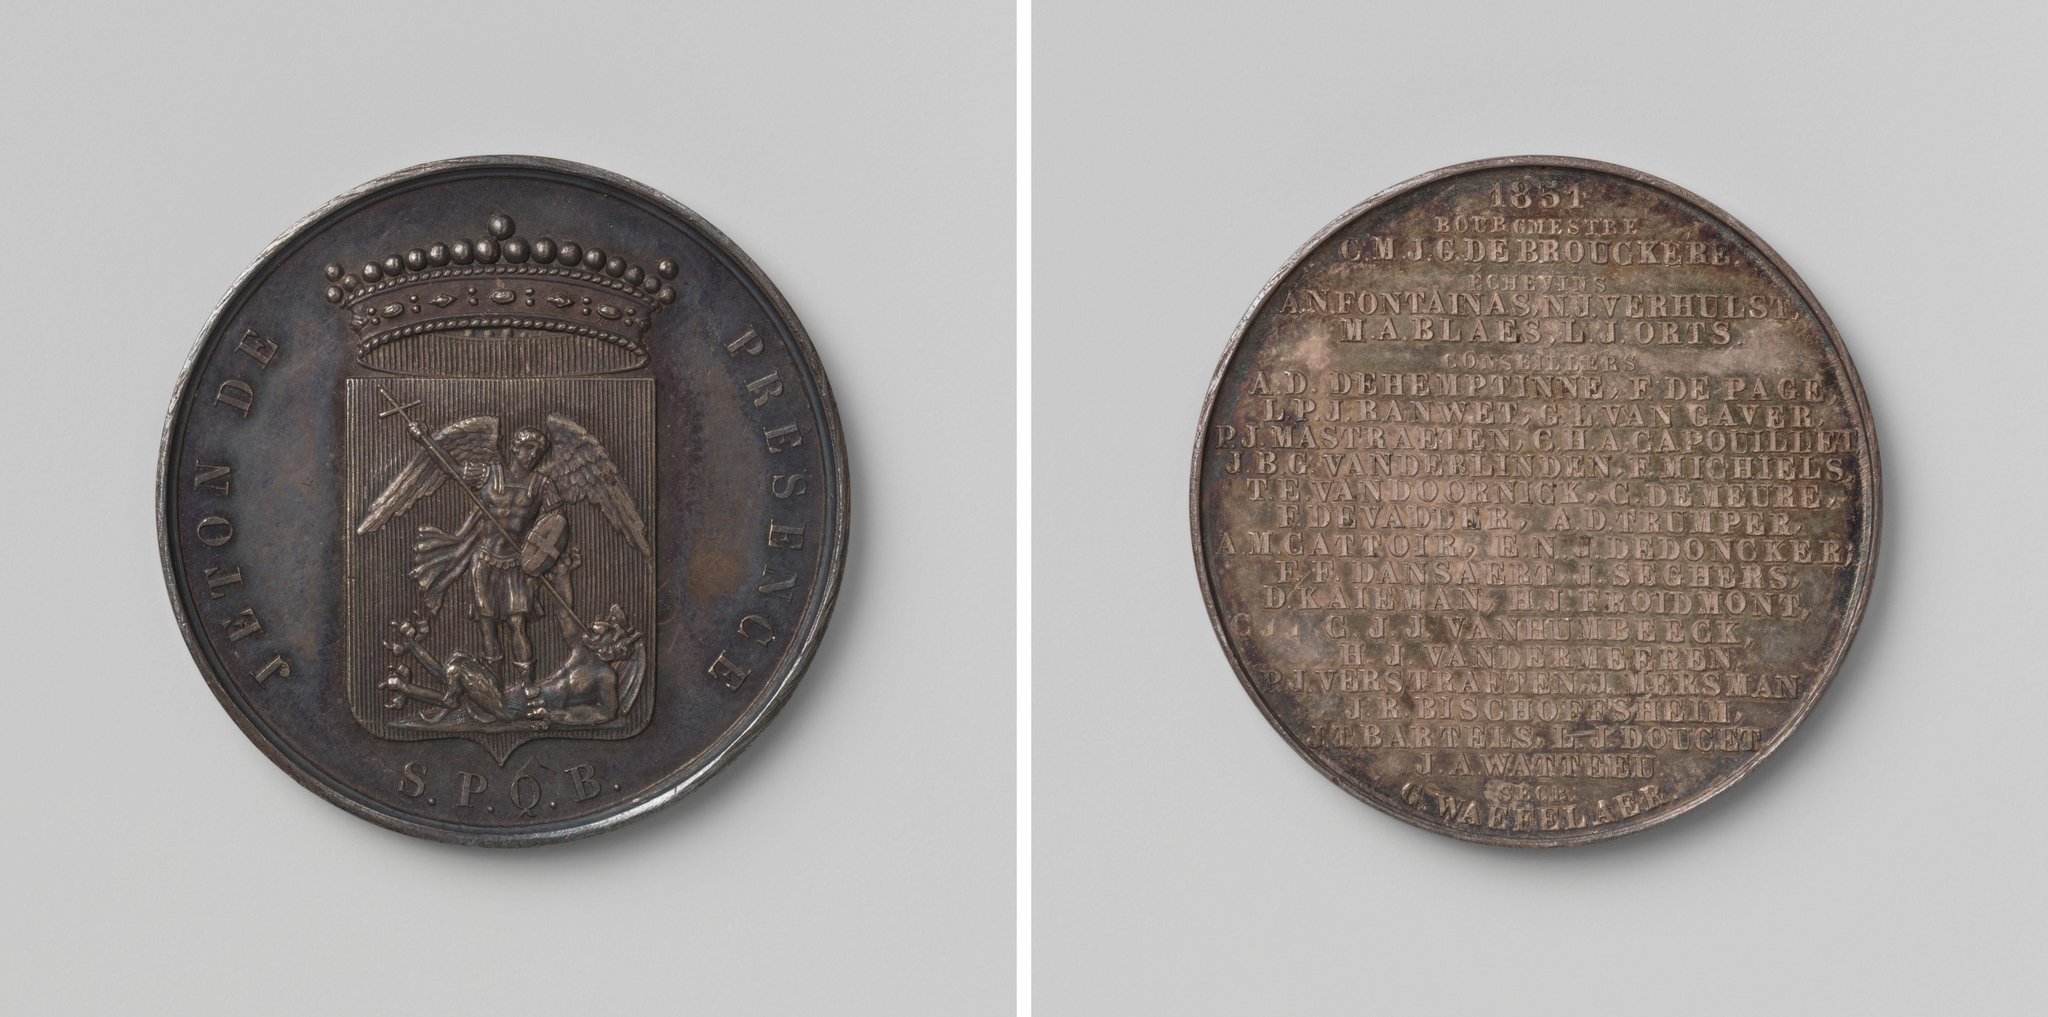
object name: raadspenning, raadsteken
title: Raadspenning van de stad Brussel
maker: Anonymous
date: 1851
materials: silver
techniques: striking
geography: brussels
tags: brussels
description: Voorzijde: gekroond wapenschild binnen omschrift. Keerzijde: opschrift, bestaande uit namen van burgemeester, schepenen, raadsleden en secretaris